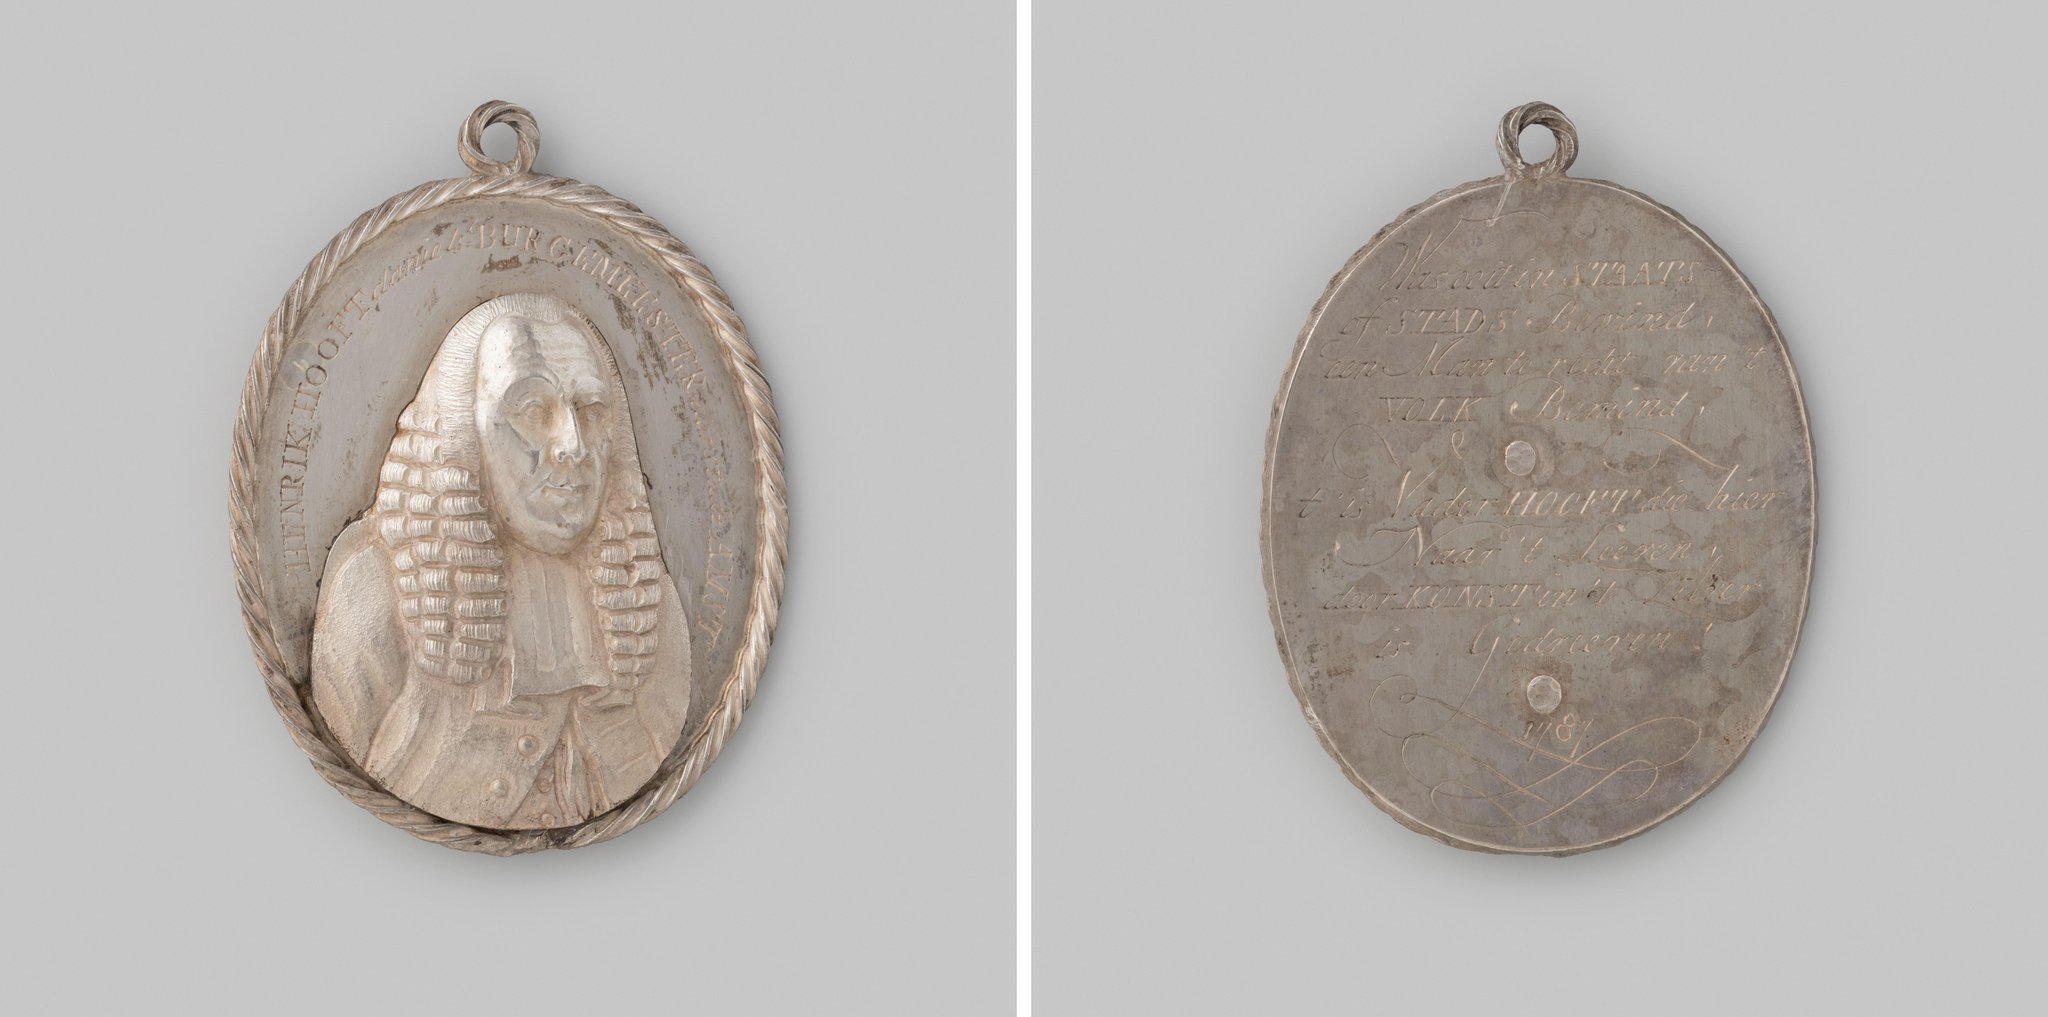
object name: insignia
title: Hendrik Danielsz. Hooft, burgemeester van Amsterdam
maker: Anonymous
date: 1787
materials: silver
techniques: casting, engraving, fastening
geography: netherlands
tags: amsterdam, mayor, hendrik danielsz. hooft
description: Zilveren ovale draagteken met kabelrand aan draagoog. Voorzijde: borststuk man binnen omschrift. Keerzijde: opschrift; op keerzijde zijn nog twee nagels zichtbaar, waarmee voor- en keerzijde aan elkaar zijn bevestigd